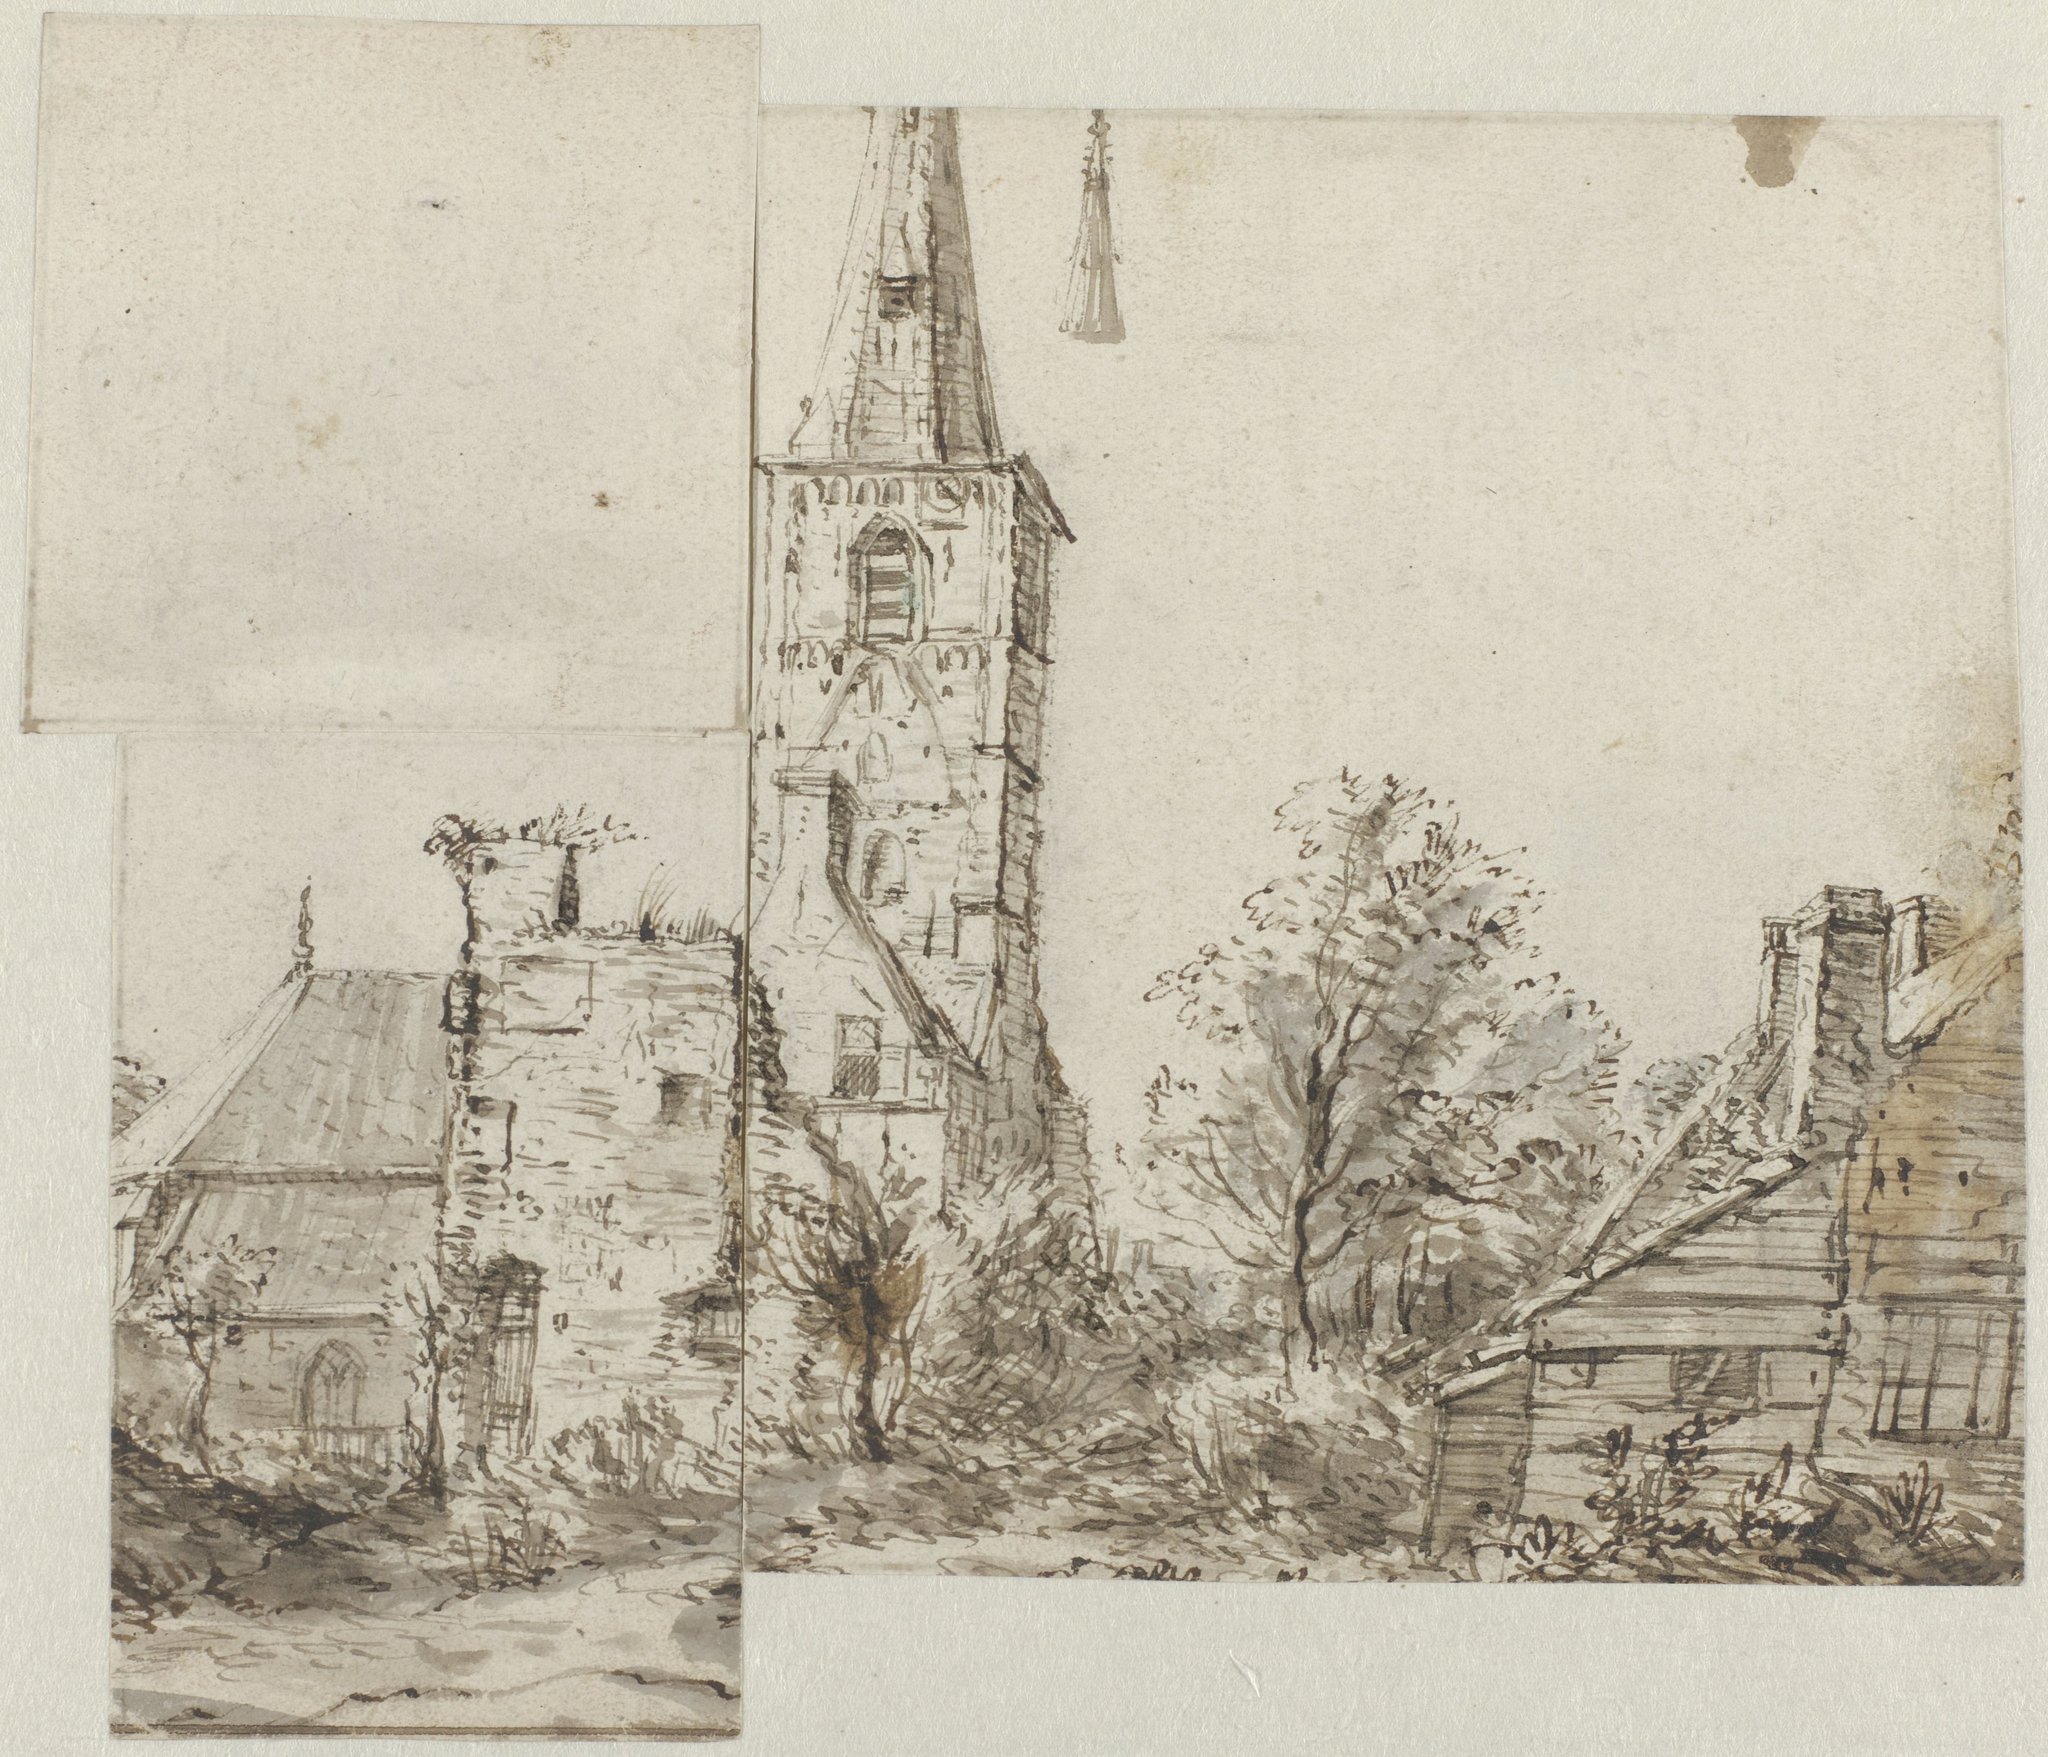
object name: drawing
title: Gezicht op de kerktoren bij Rijnsburg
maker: isaac van ostade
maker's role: draughtsman, painter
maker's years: 1621-1649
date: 1631-1649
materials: ink, paper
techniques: pen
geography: netherlands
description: De tekening is in drie stukken gesneden.